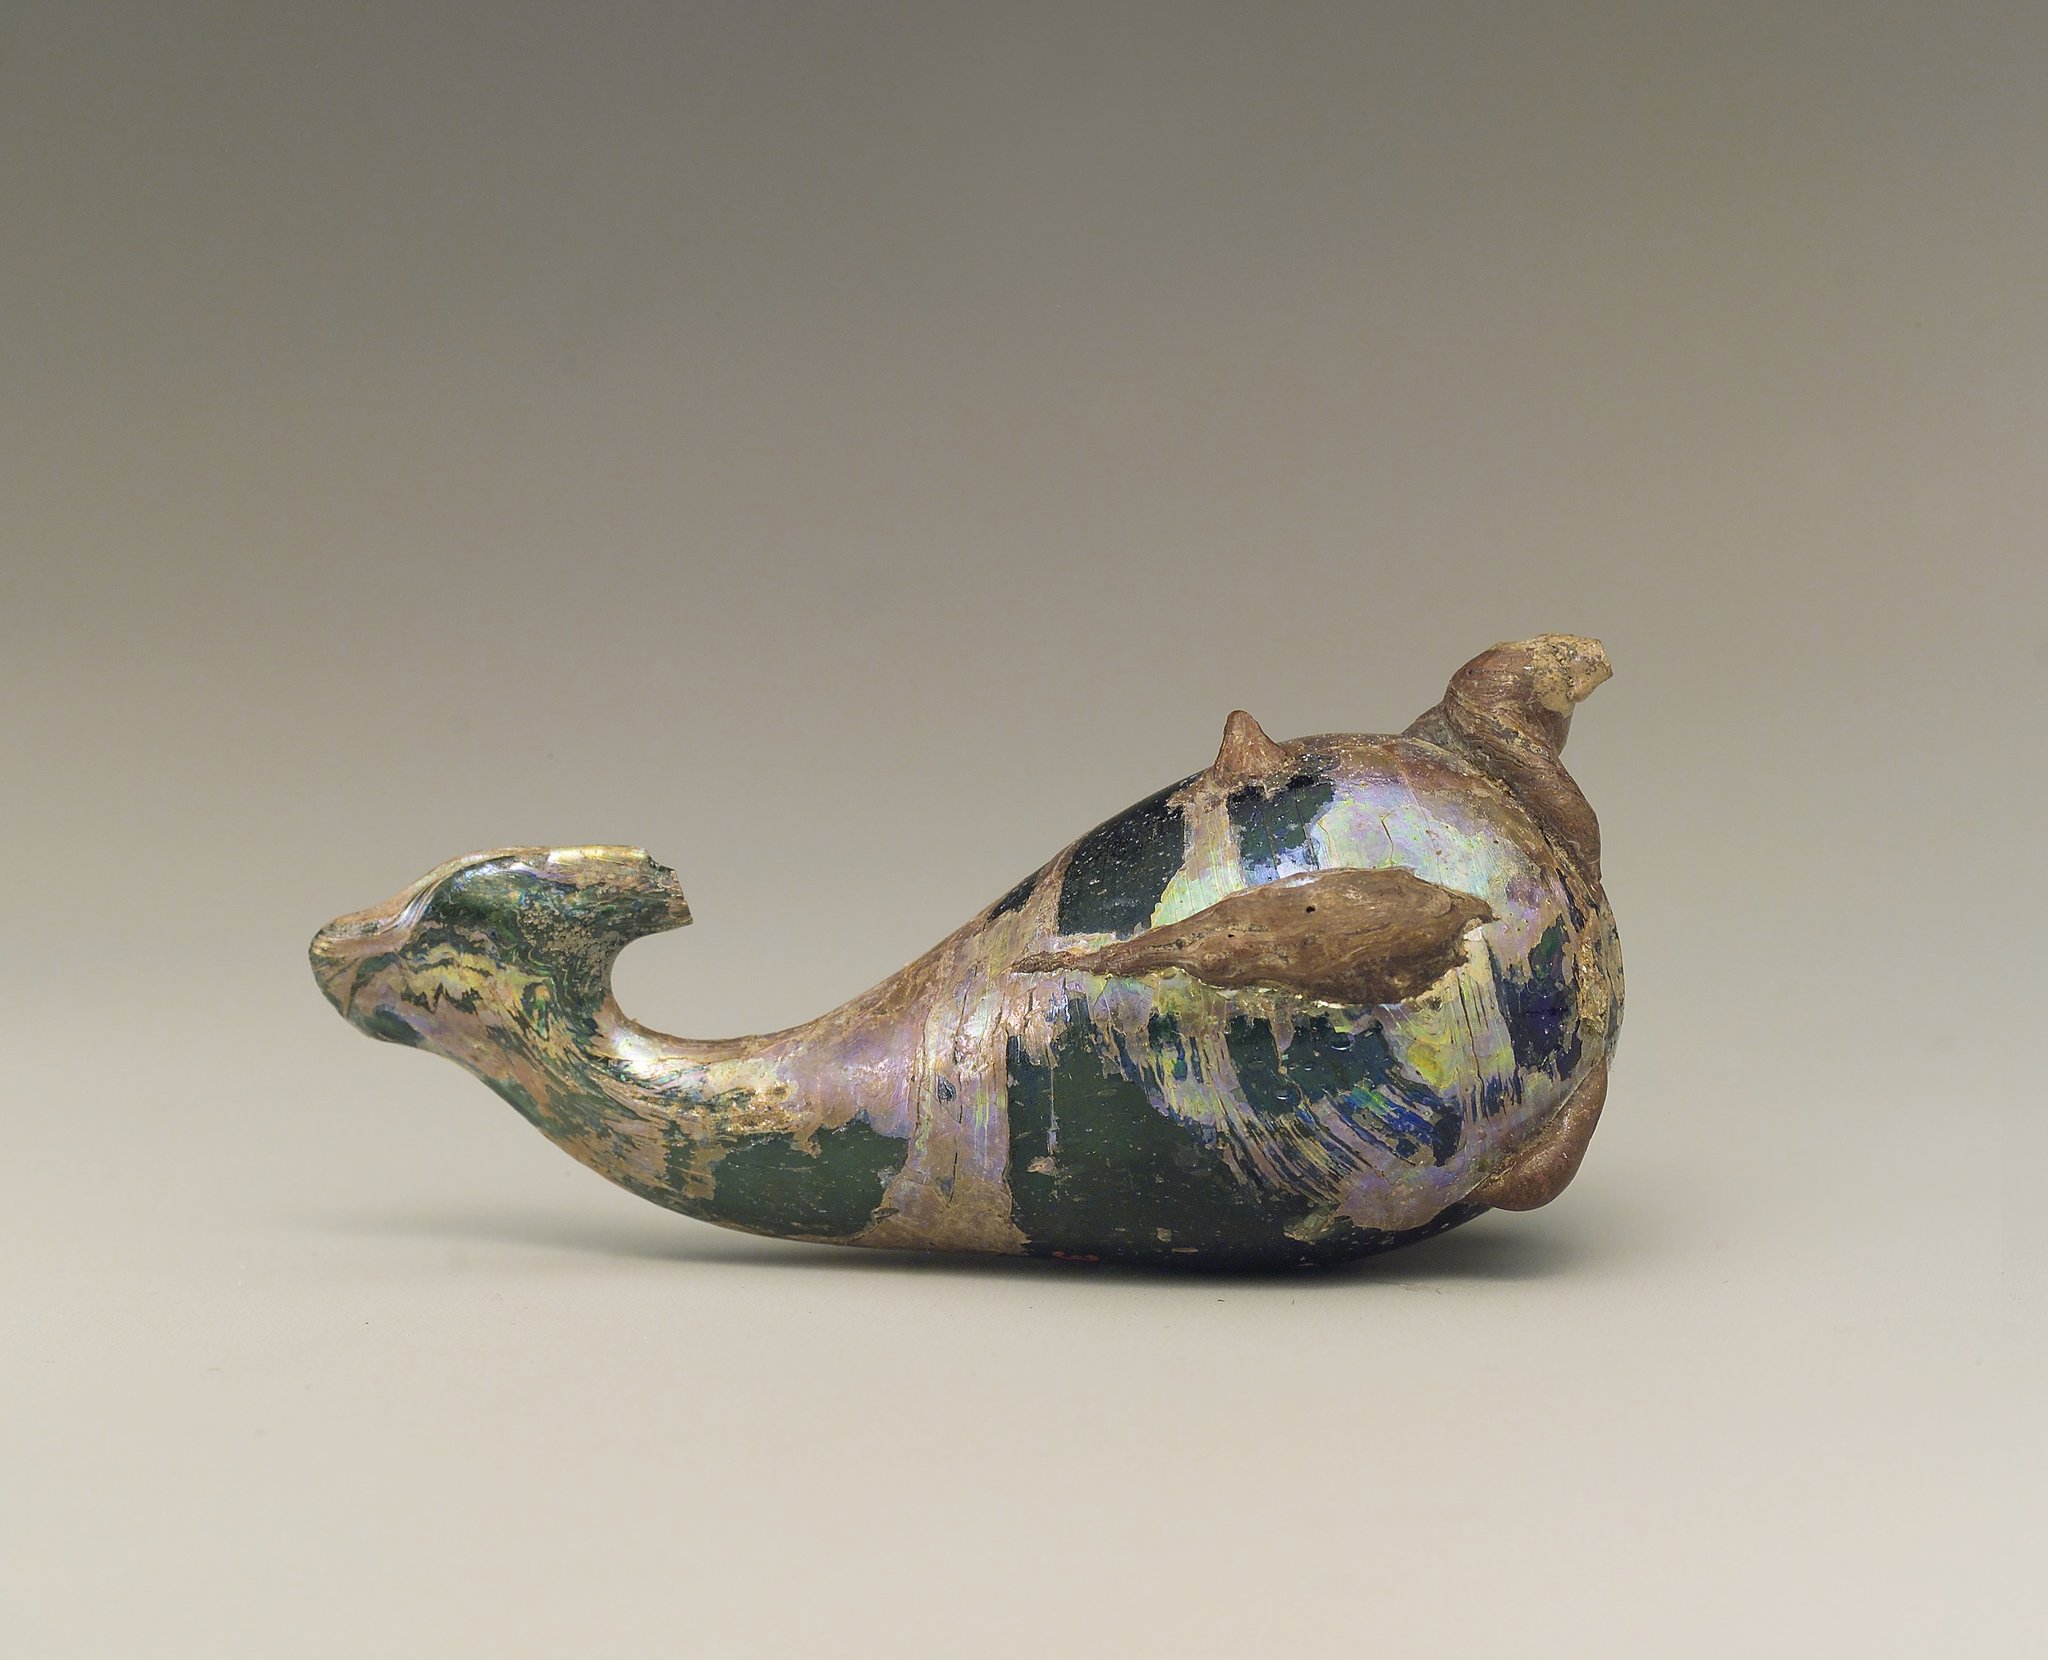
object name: pendant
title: Bird-shaped Pendant with Brown Wings (Toy?)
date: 1201-1300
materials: glass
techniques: glassblowing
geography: syria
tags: birds